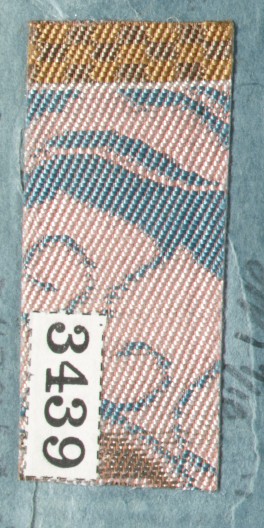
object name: textile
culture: japanese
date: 1801-1900